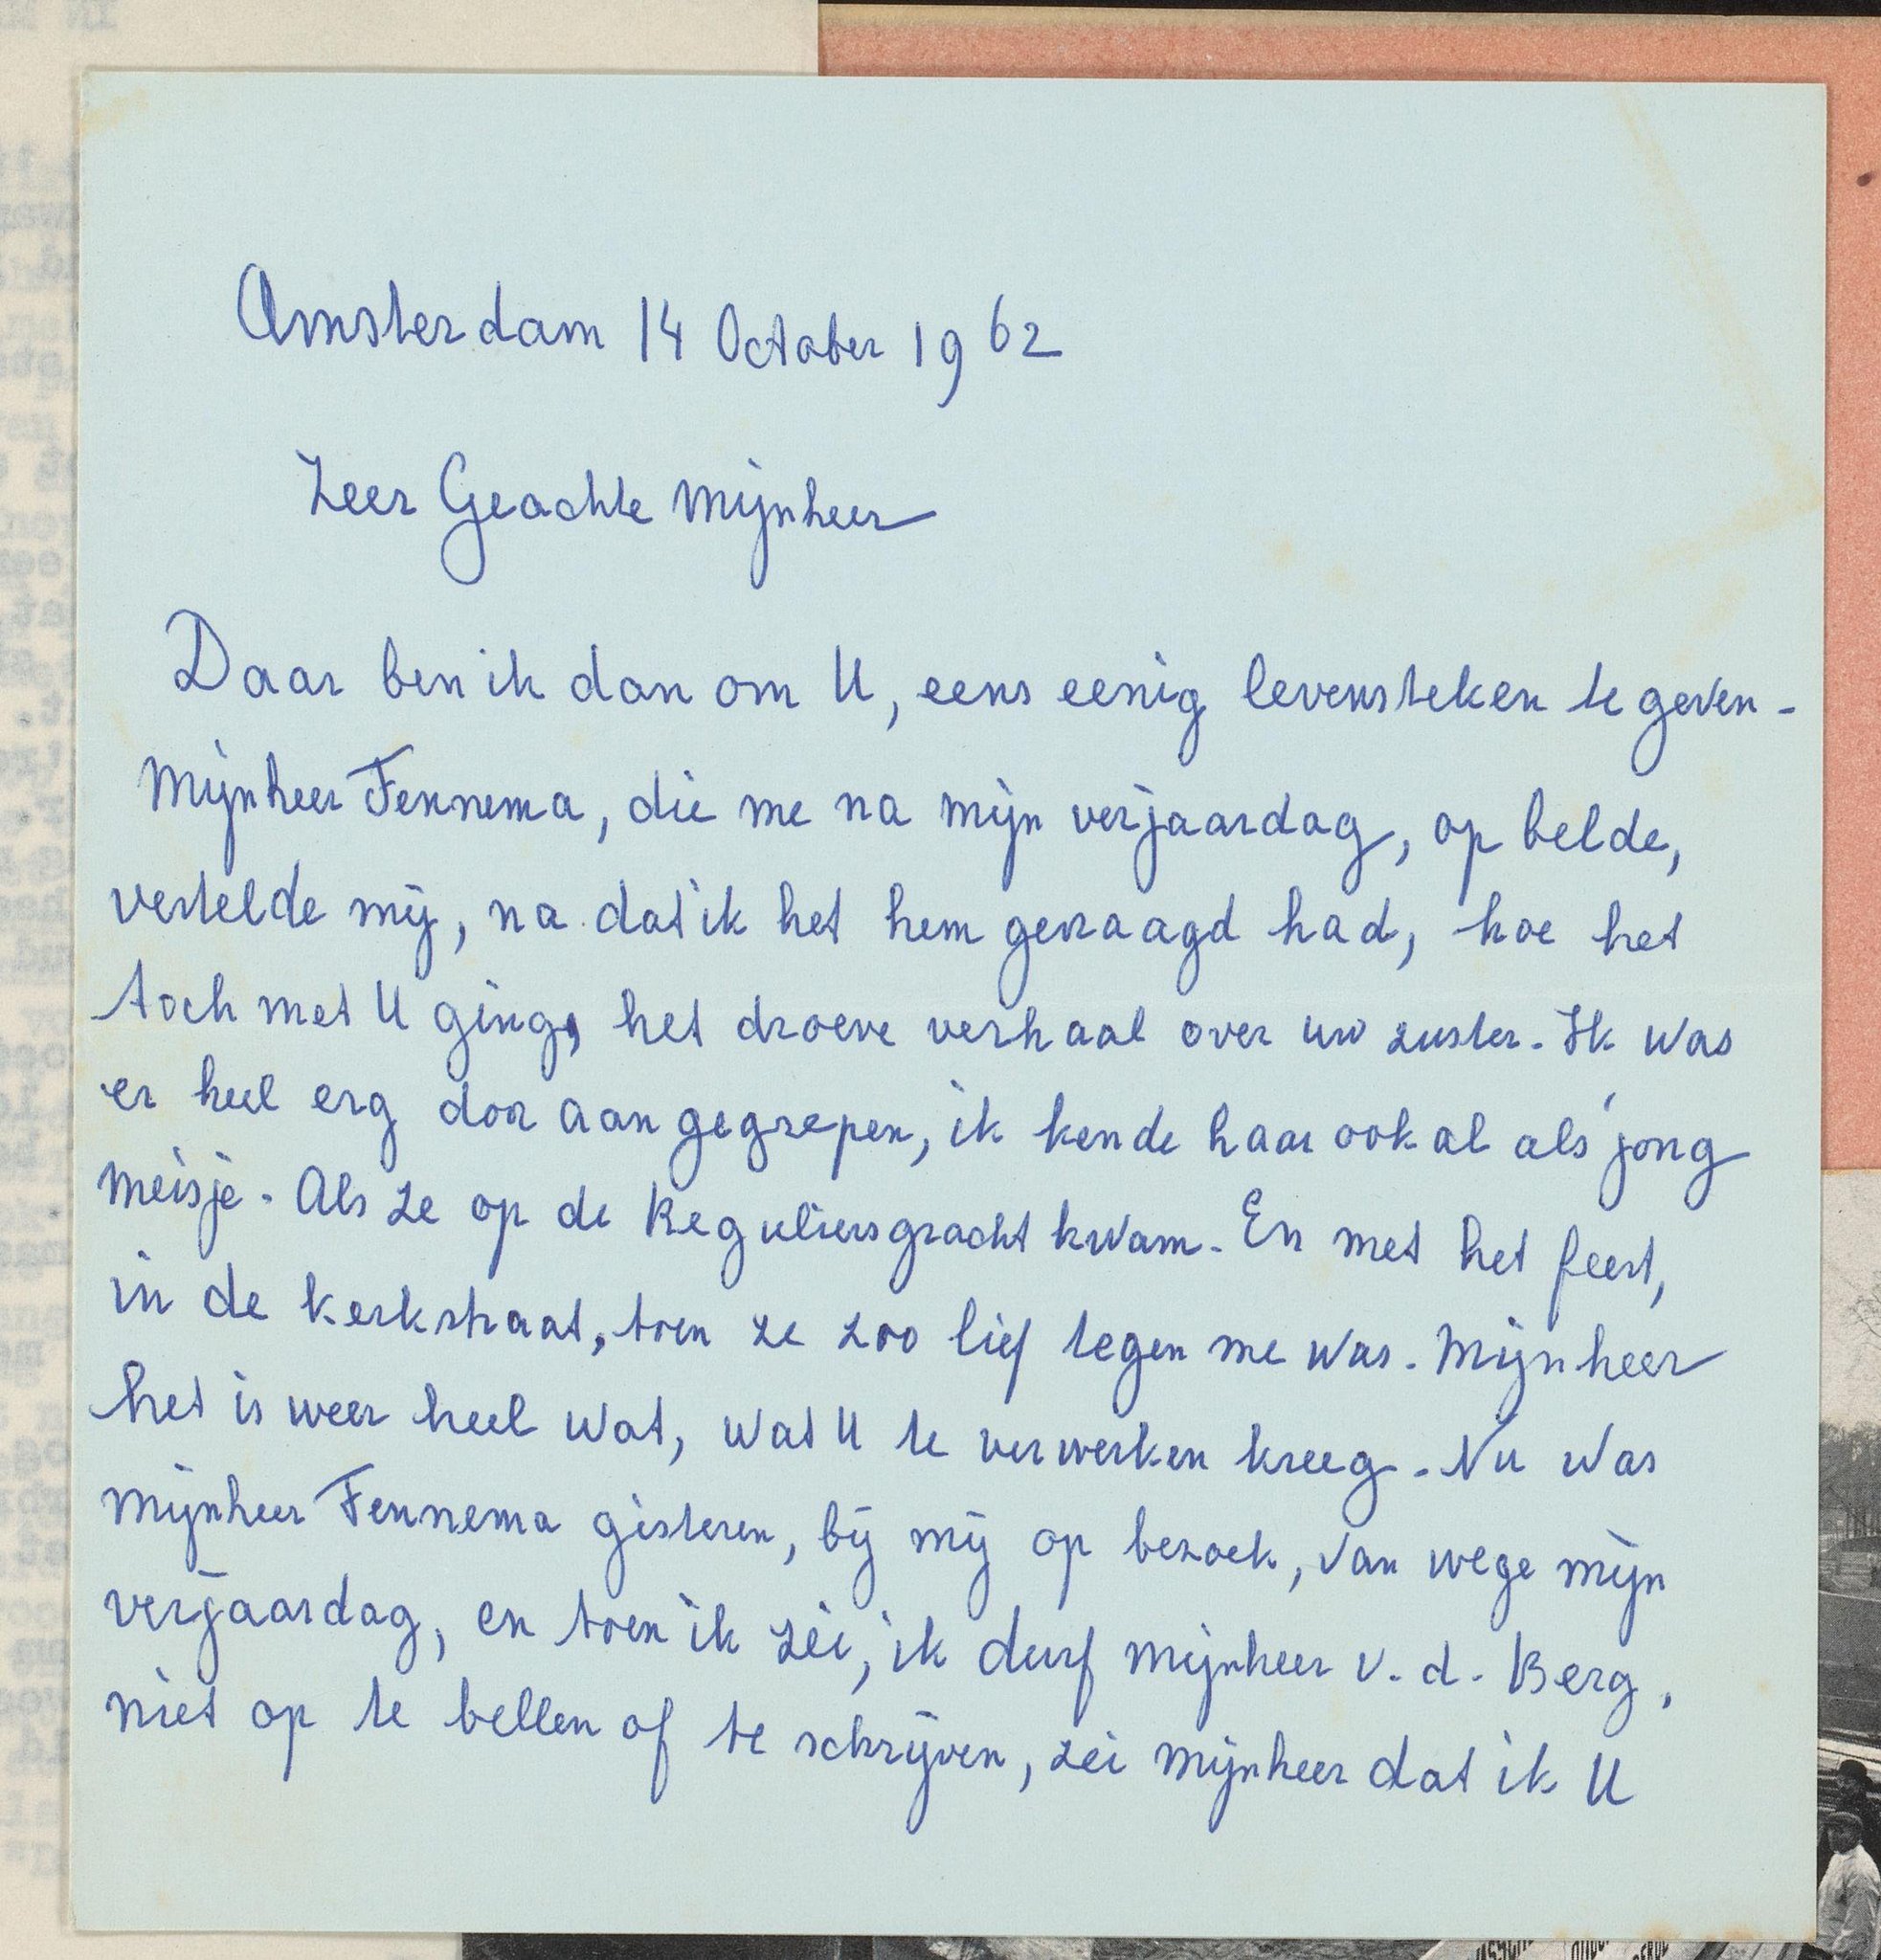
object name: letter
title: Brief van de huishoudster Anna aan Norbert van den Berg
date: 1962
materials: paper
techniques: handwriting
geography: netherlands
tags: reguliersgracht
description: Brief van de huishoudster Anna aan de heer Norbert van den Berg, gedateerd 14 oktober 1962. Los object behorend bij albumblad nr. 12 in het fotoalbum over de bewoners van het huis aan de Reguliersgracht te Amsterdam in de periode 1924-1932.